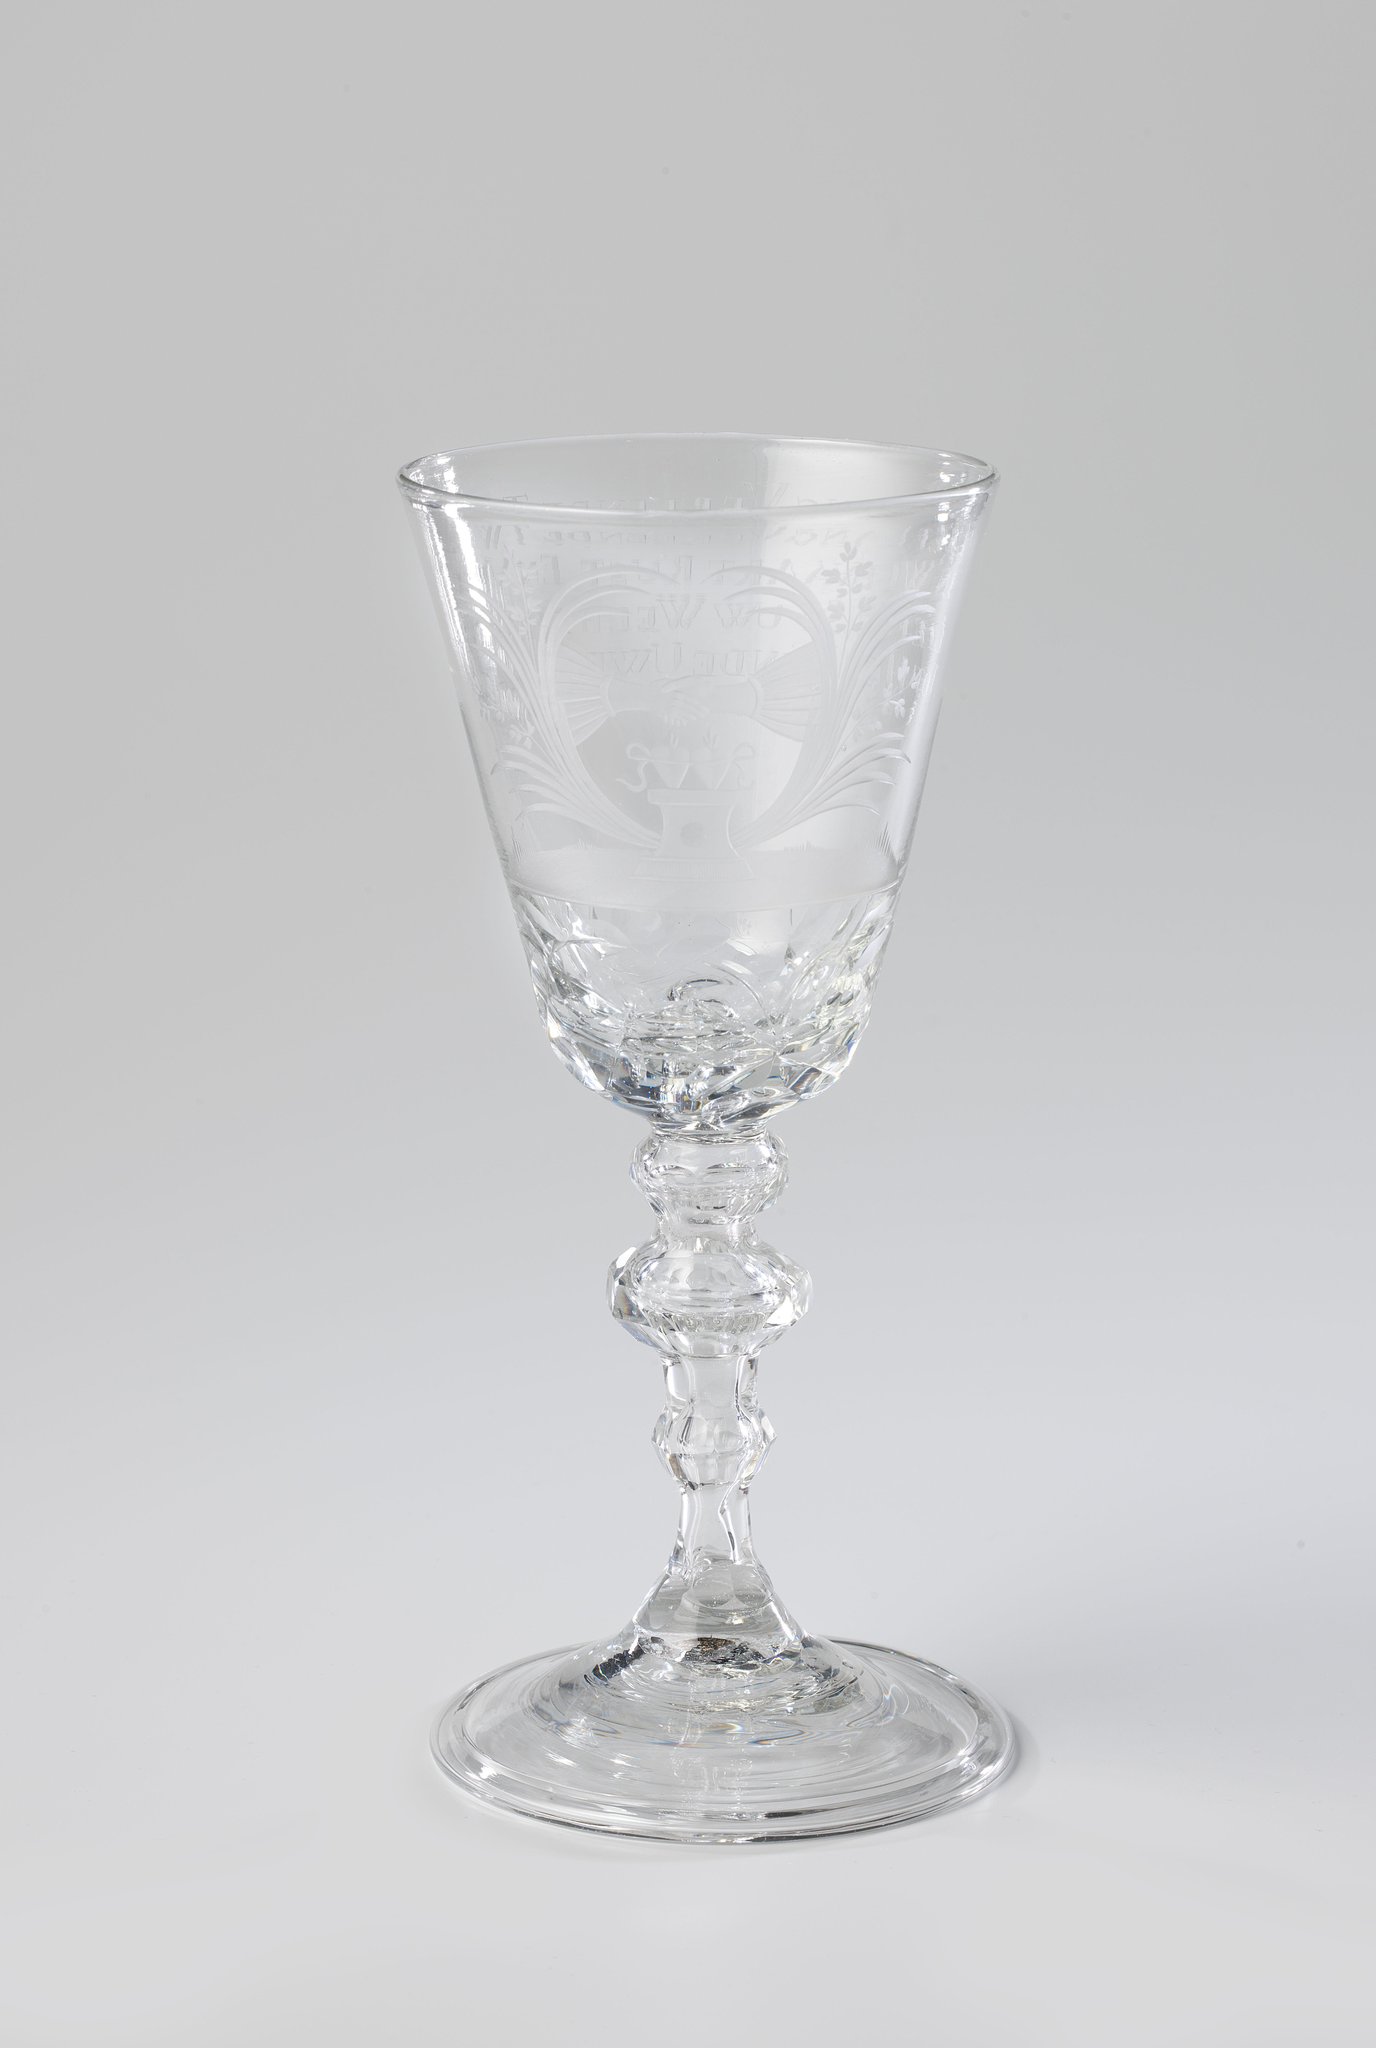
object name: goblet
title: Bokaal met twee ineengeslagen handen en opschrift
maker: Anonymous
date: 1725-1750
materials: glass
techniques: glassblowing, grinding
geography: northern netherlands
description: Bokaal met facetten geslepen balusterstam in drie geledingen. Op de kelk geslepen twee handen ineen gestrengeld boven twee harten omgeven door palmtakken en toepasselijk vierregelig vers: LEEF LANG VEREENDE TWEE/ IN WELVAART RUST EN VREE/ LIEFDE SY UW WELBEHAGEN/ TOT HET EINDE UWER DAAGEN.